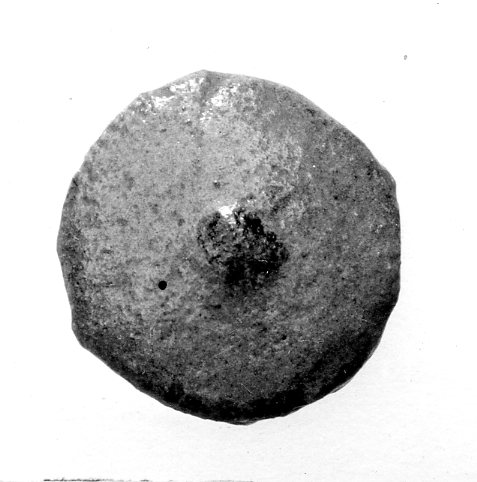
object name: bead, disk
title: Disk bead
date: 664-332 BCE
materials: faience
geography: egypt